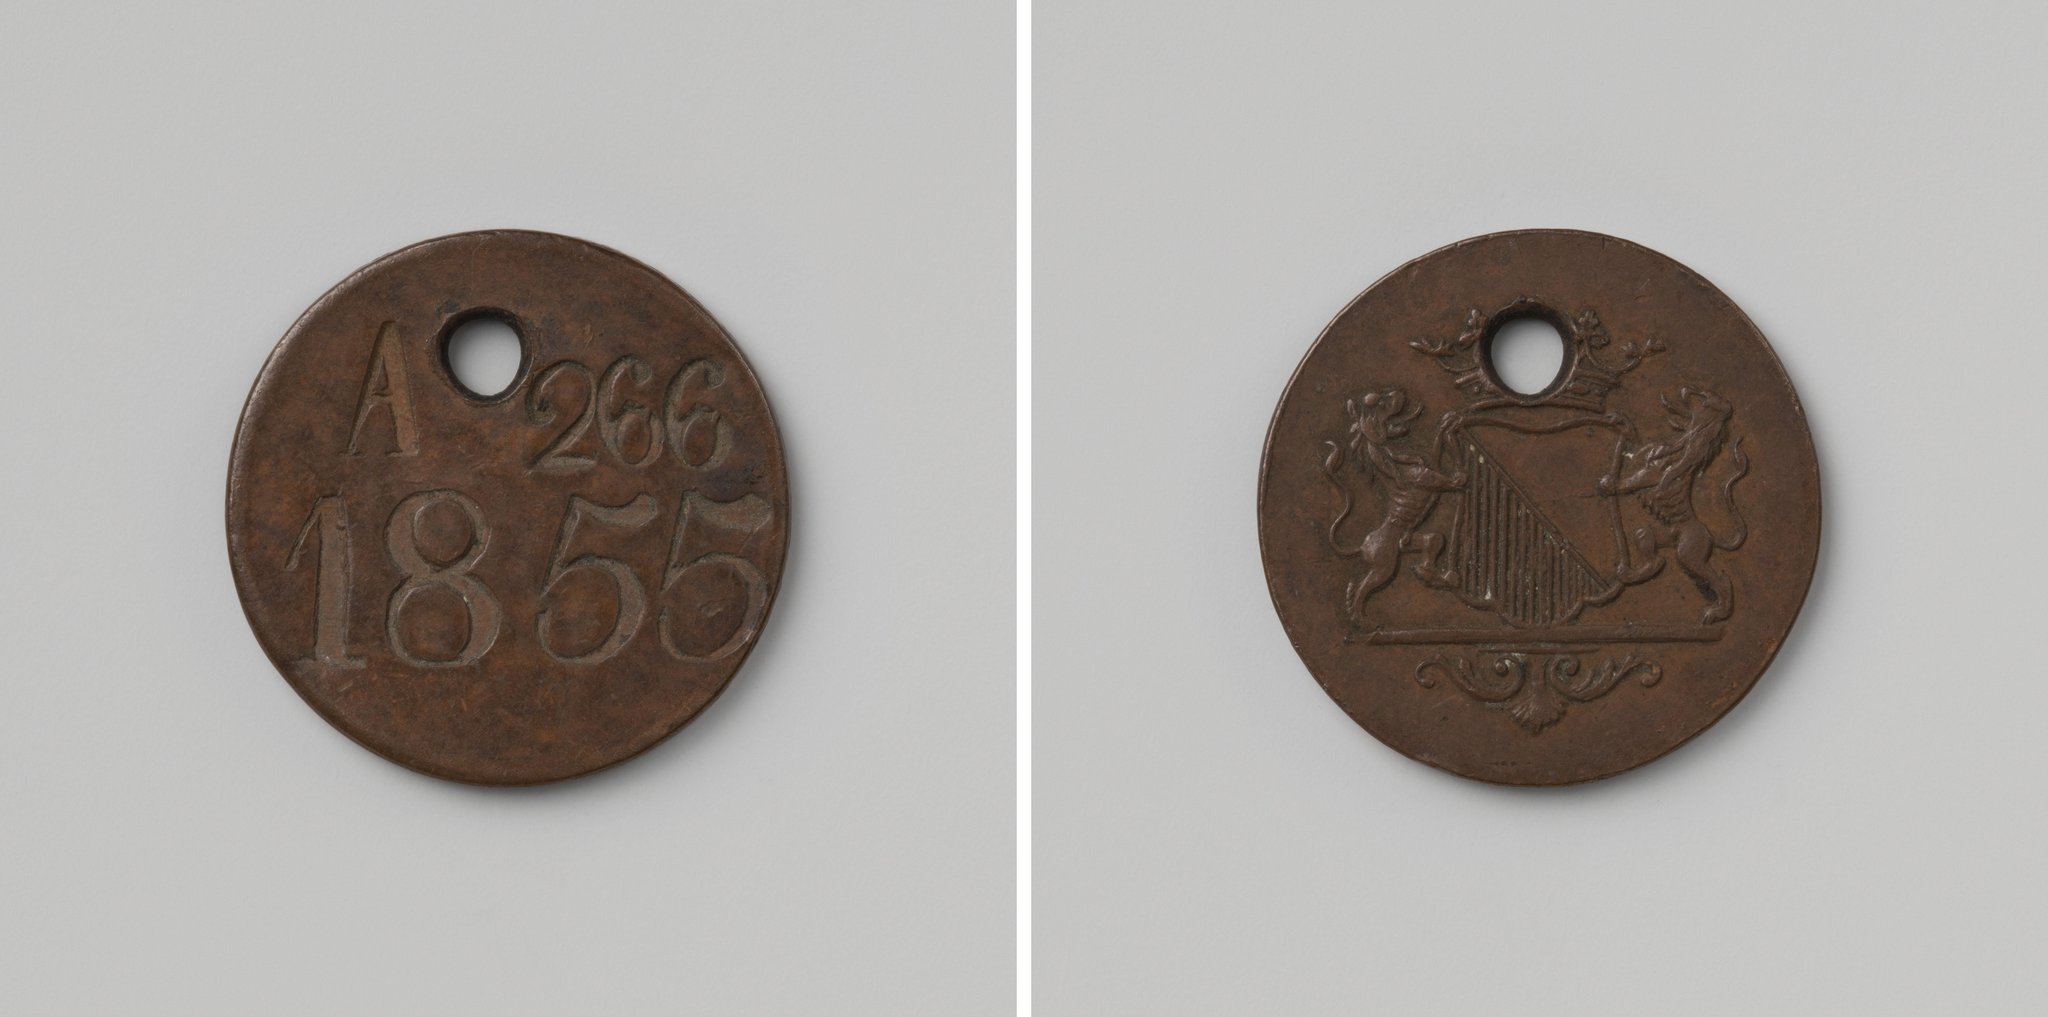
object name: hondenbelastingloodje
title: Stad Utrecht, loodje met letter A en no. 266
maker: Anonymous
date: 1855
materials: copper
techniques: striking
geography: utrecht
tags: utrecht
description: loodje met gat erin. Voorzijde: letter A en cijfer 266 boven jaartal. Keerzijde: gekroond wapenschild, geflankeerd door twee leeuwen